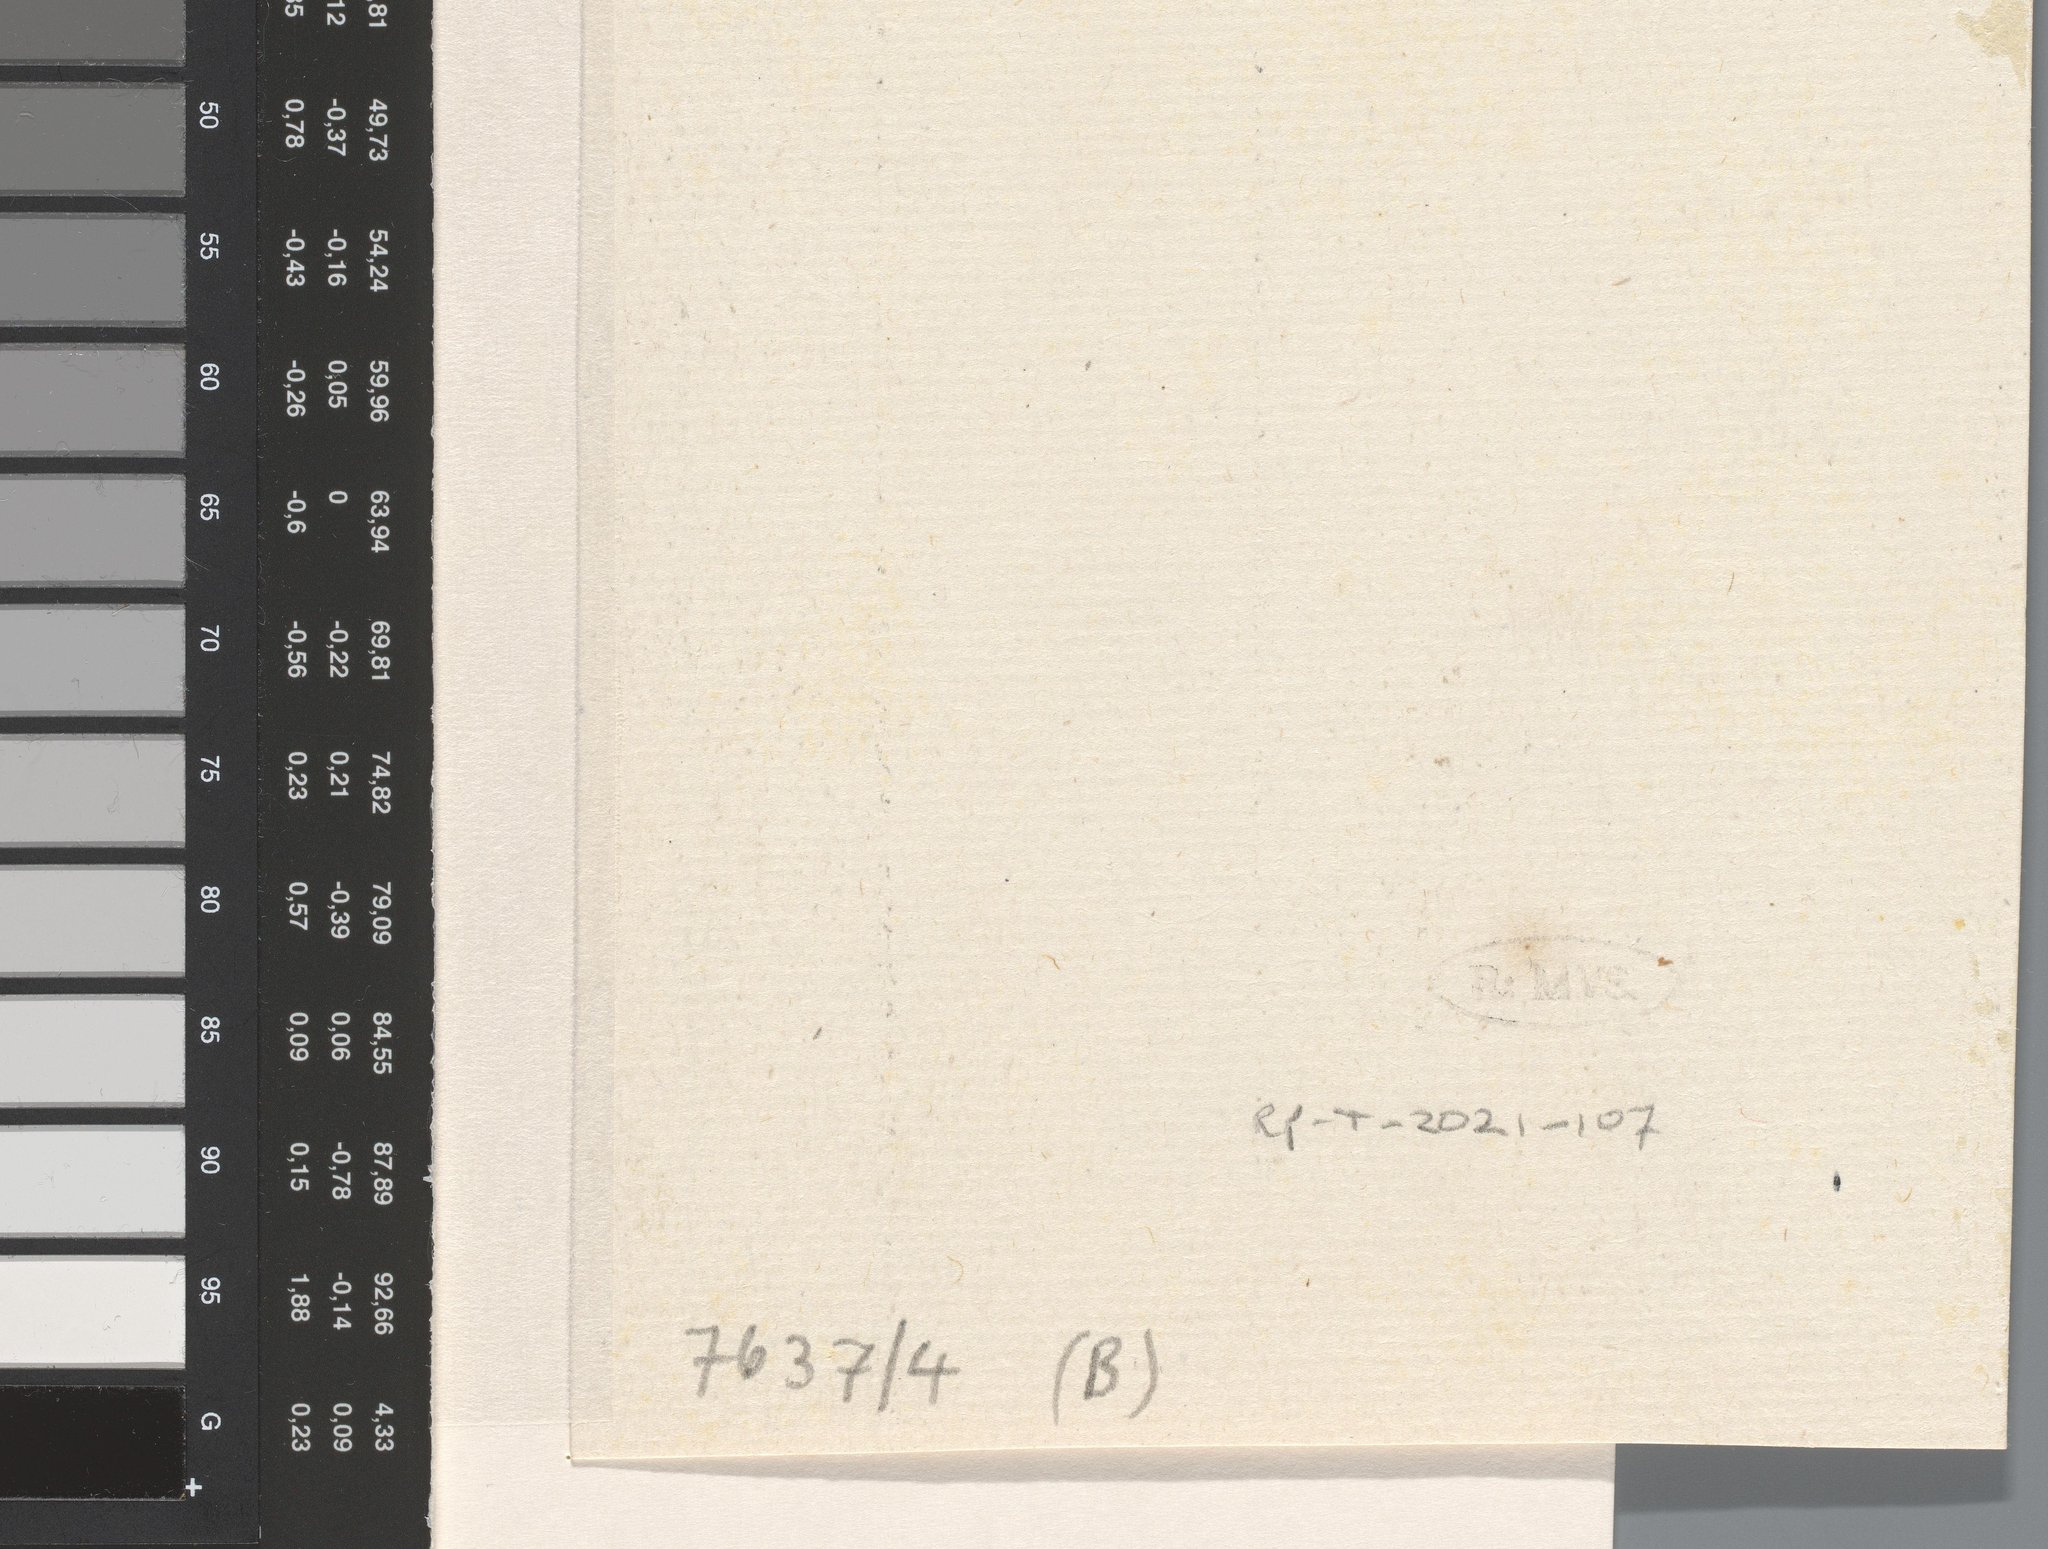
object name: drawing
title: ontwerp voor de linkerhelft van een vaas, met een oor in de vorm van een ramskop met een cornucopia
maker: Anonymous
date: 1760-1780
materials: chalk, ink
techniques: drawing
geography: italy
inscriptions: collector's mark: ‘Lodewijk Houthakker (1926-2008)’ Lugt 3893, collector's mark: ‘Edmond Fatio (1871-1959)’ Lugt 3472